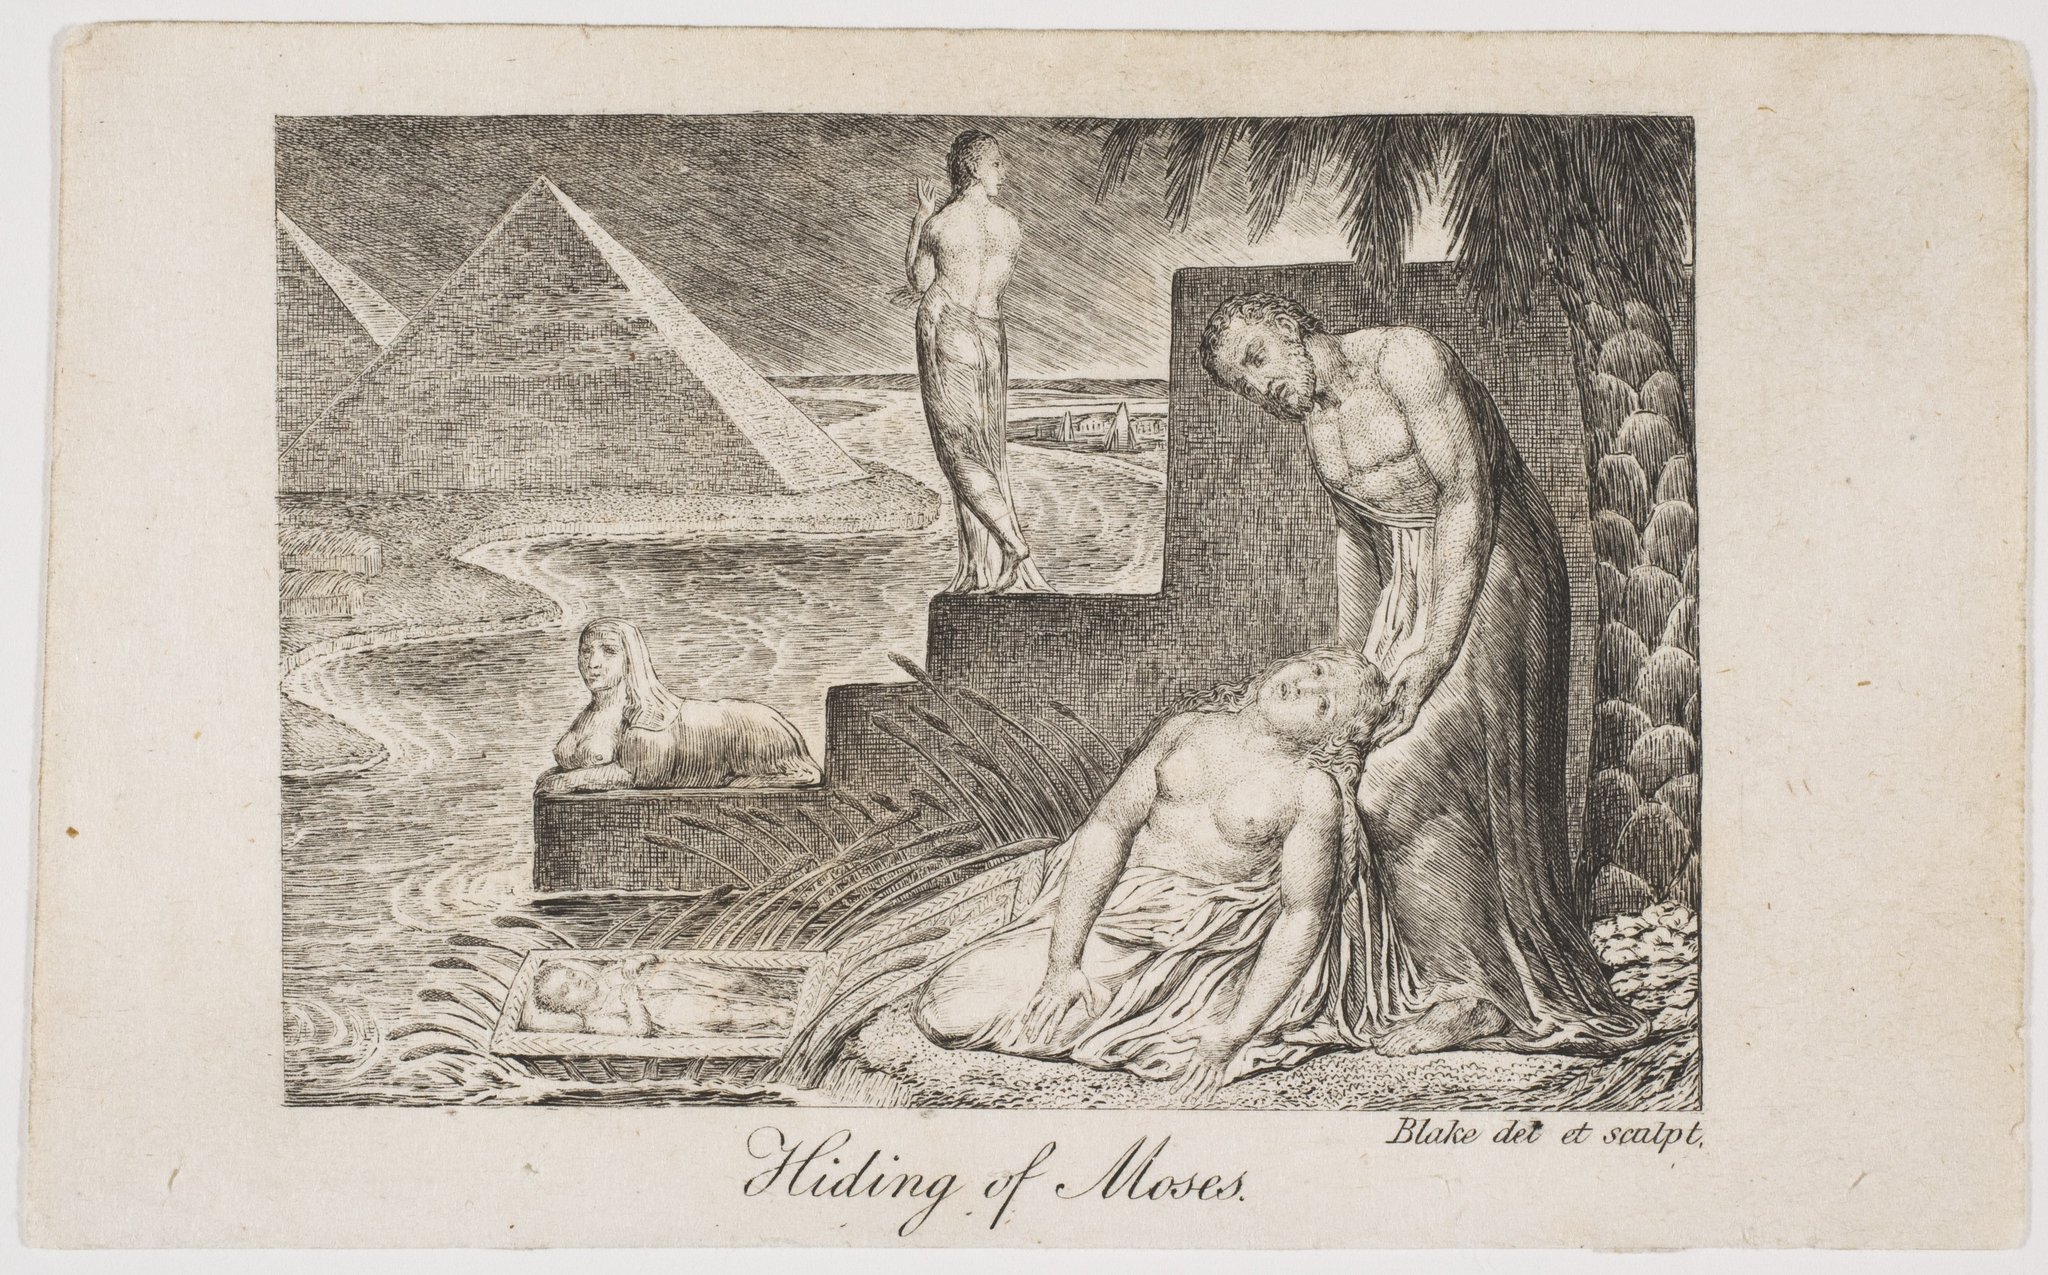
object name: print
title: Hiding of Moses, from "Remember Me!, or a Pocket Companion"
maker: william blake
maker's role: artist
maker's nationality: british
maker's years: 1757-1827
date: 1825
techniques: engraving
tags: pyramids,men,female nudes,sphinx,moses